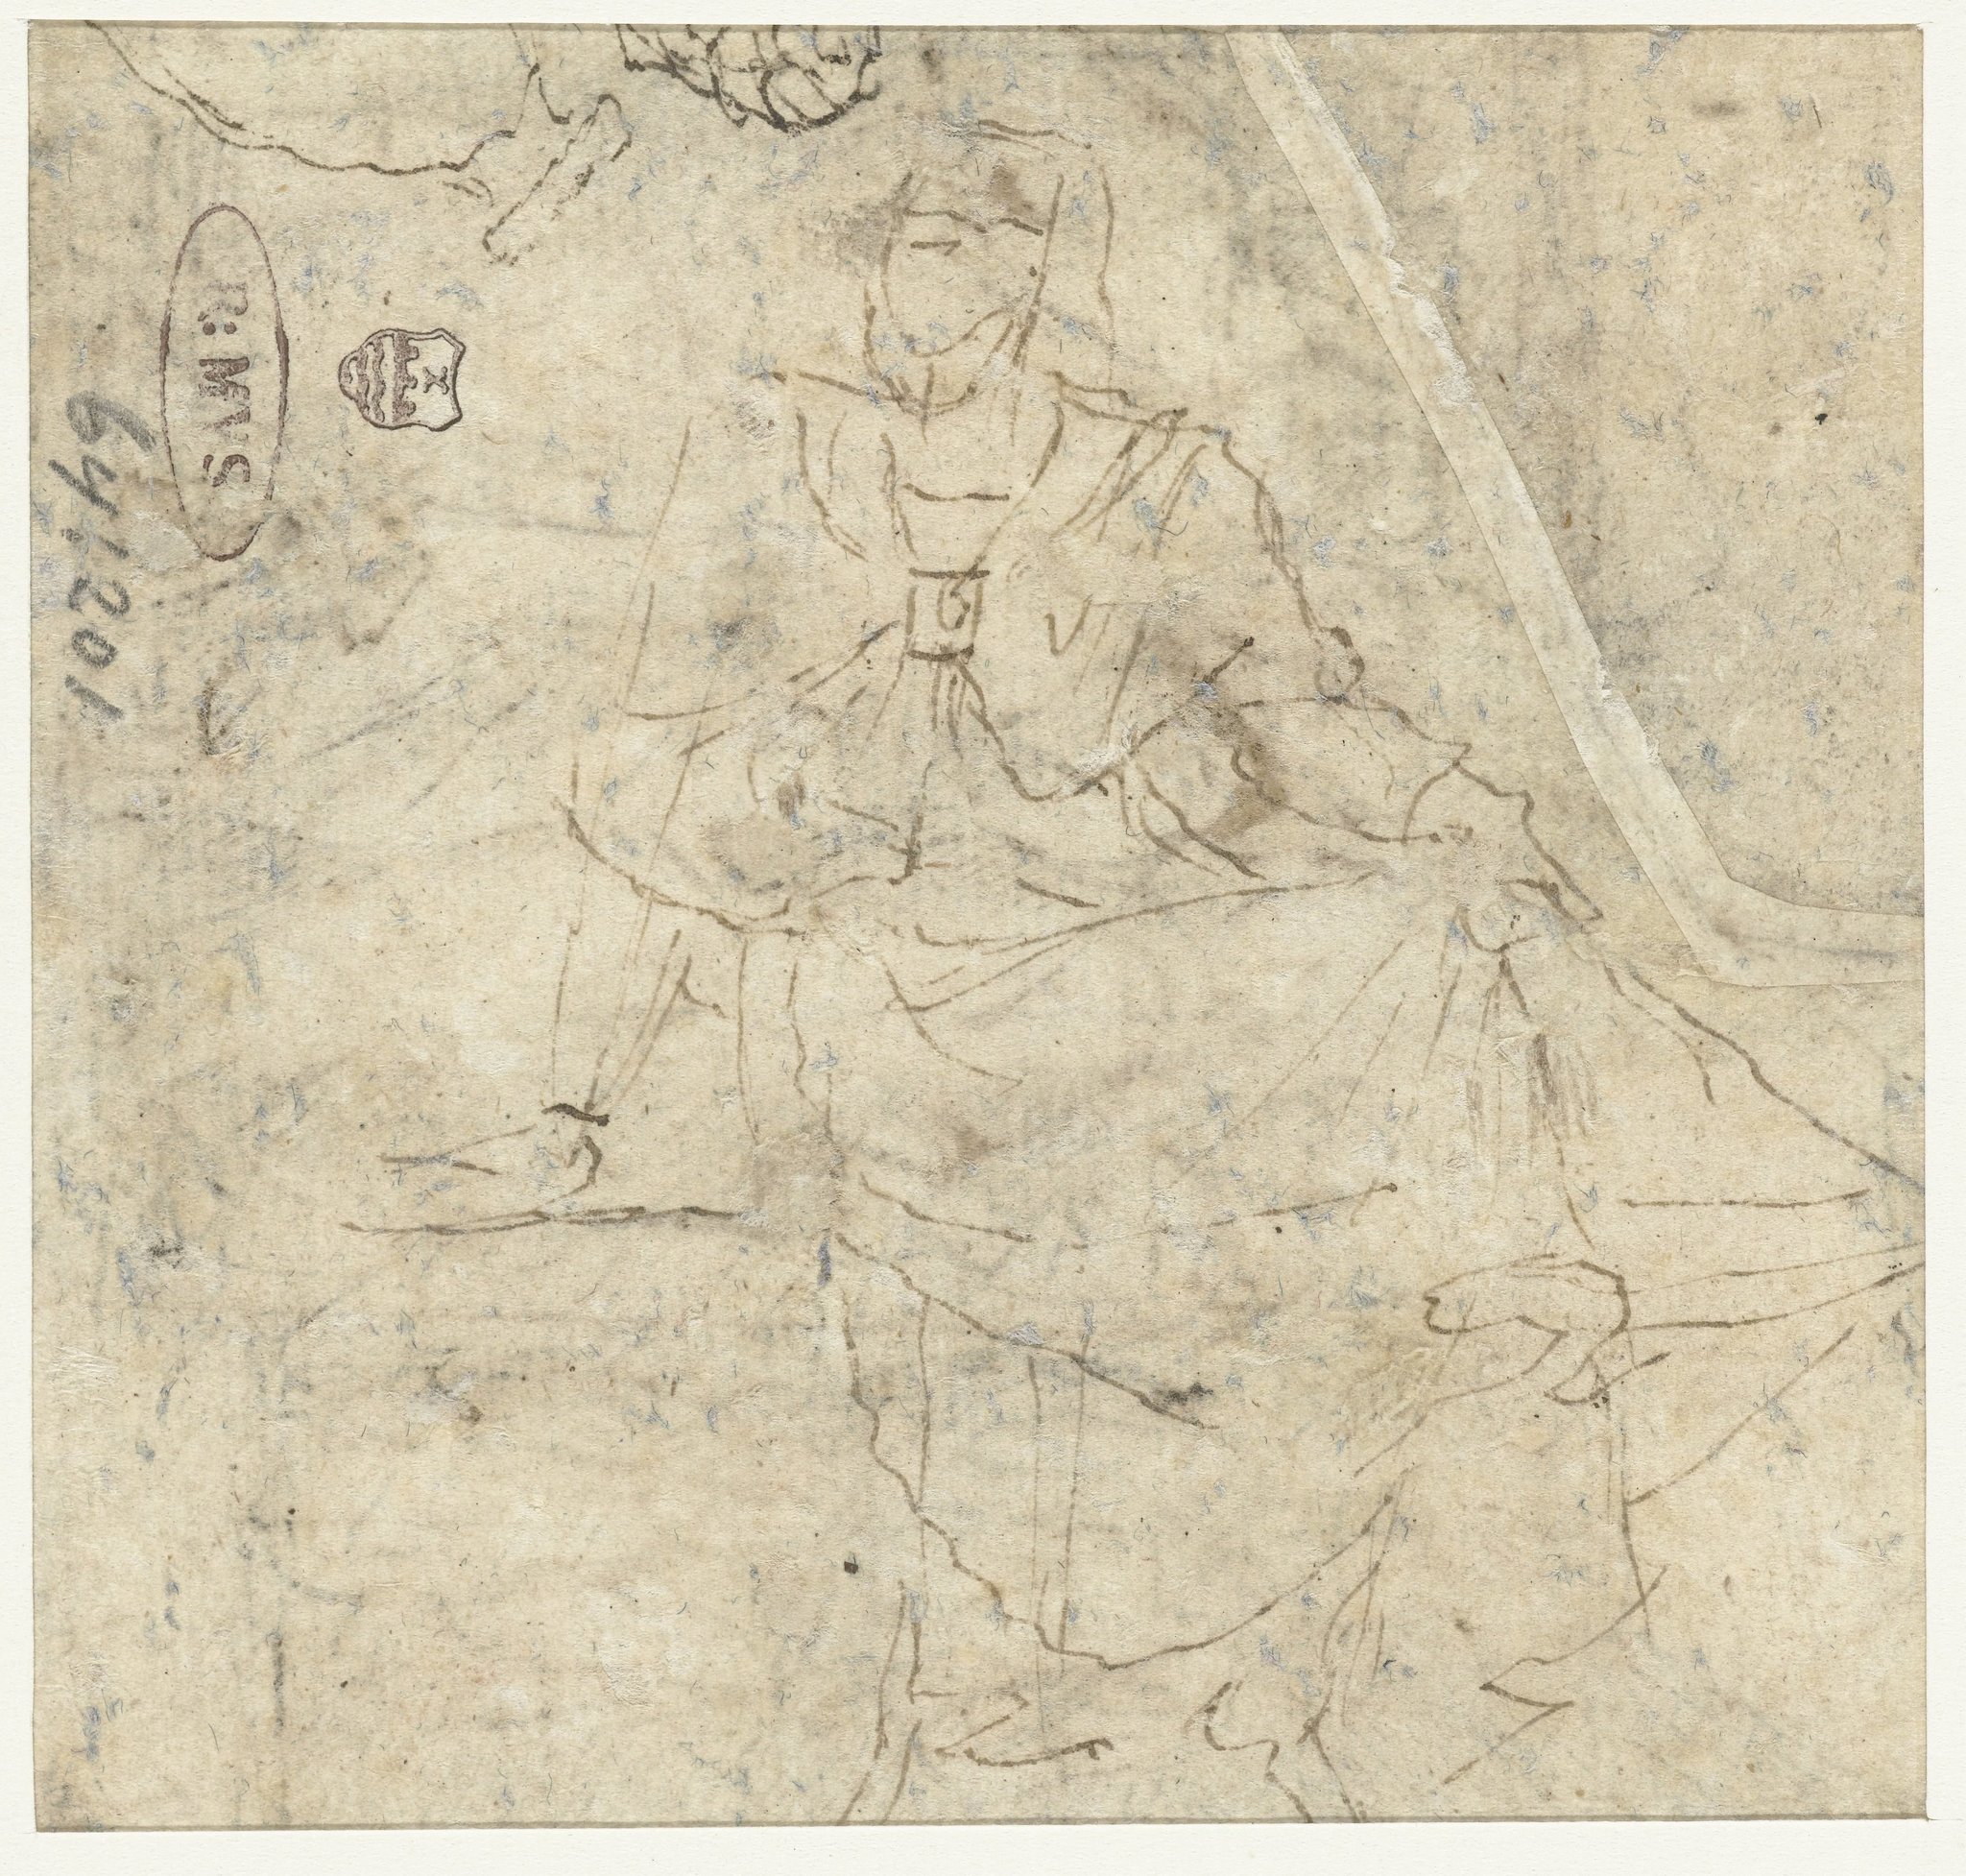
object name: drawing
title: Zittende vrouwenfiguur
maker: nicolas poussin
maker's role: draughtsman, painter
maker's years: 1593-1665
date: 1642-1644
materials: ink, paper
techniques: pen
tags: sitting figure - aa - female human figure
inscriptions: collector's mark: Lugt 2760, collector's mark: Lugt 2228